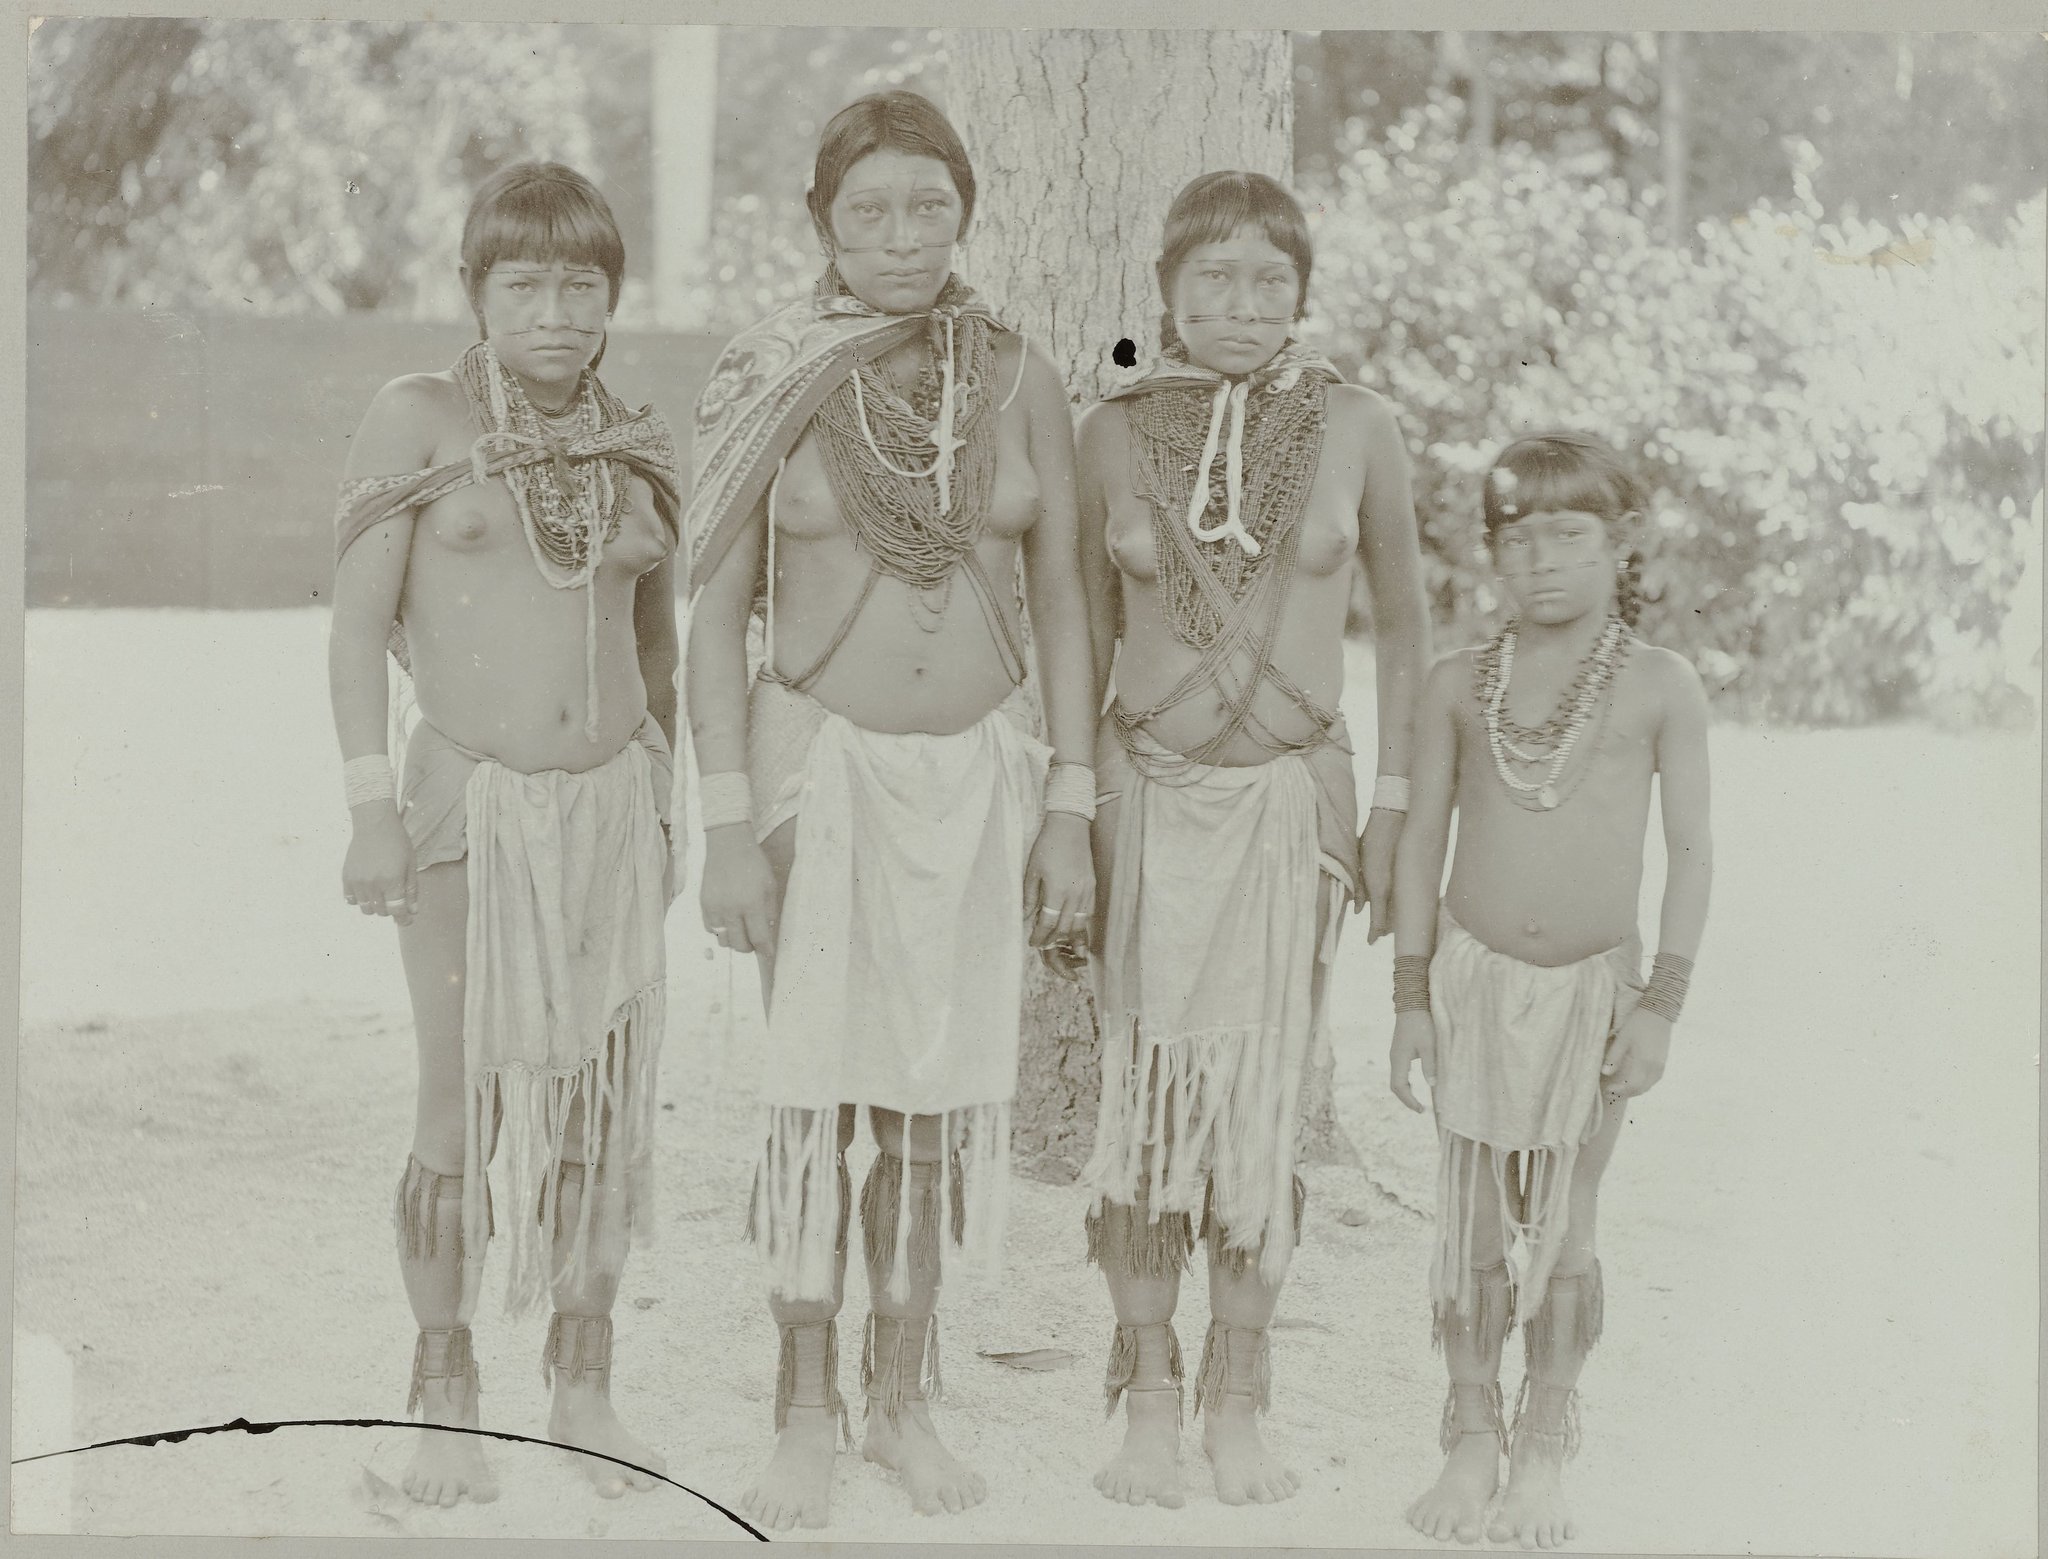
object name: photograph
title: Surinaamse Caraïben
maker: julius muller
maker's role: official, politician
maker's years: 1846-1902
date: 1885-1895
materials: photographic support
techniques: collodion silver print, gelatin silver print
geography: suriname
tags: indigenous peoples of south america, suriname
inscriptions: inscription: ‘Indianen, cliché Muller.’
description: Vier indiaanse meisjes van de Karaïben stam uit de Casipoere kreek poseren in de tuin van het Gouvernementshuis in Paramaribo. Onderdeel van het fotoalbum Souvenir de Voyage (deel 3), over het leven van de familie Dooyer in en rond de plantage Ma Retraite in Suriname in de jaren 1906-1913.